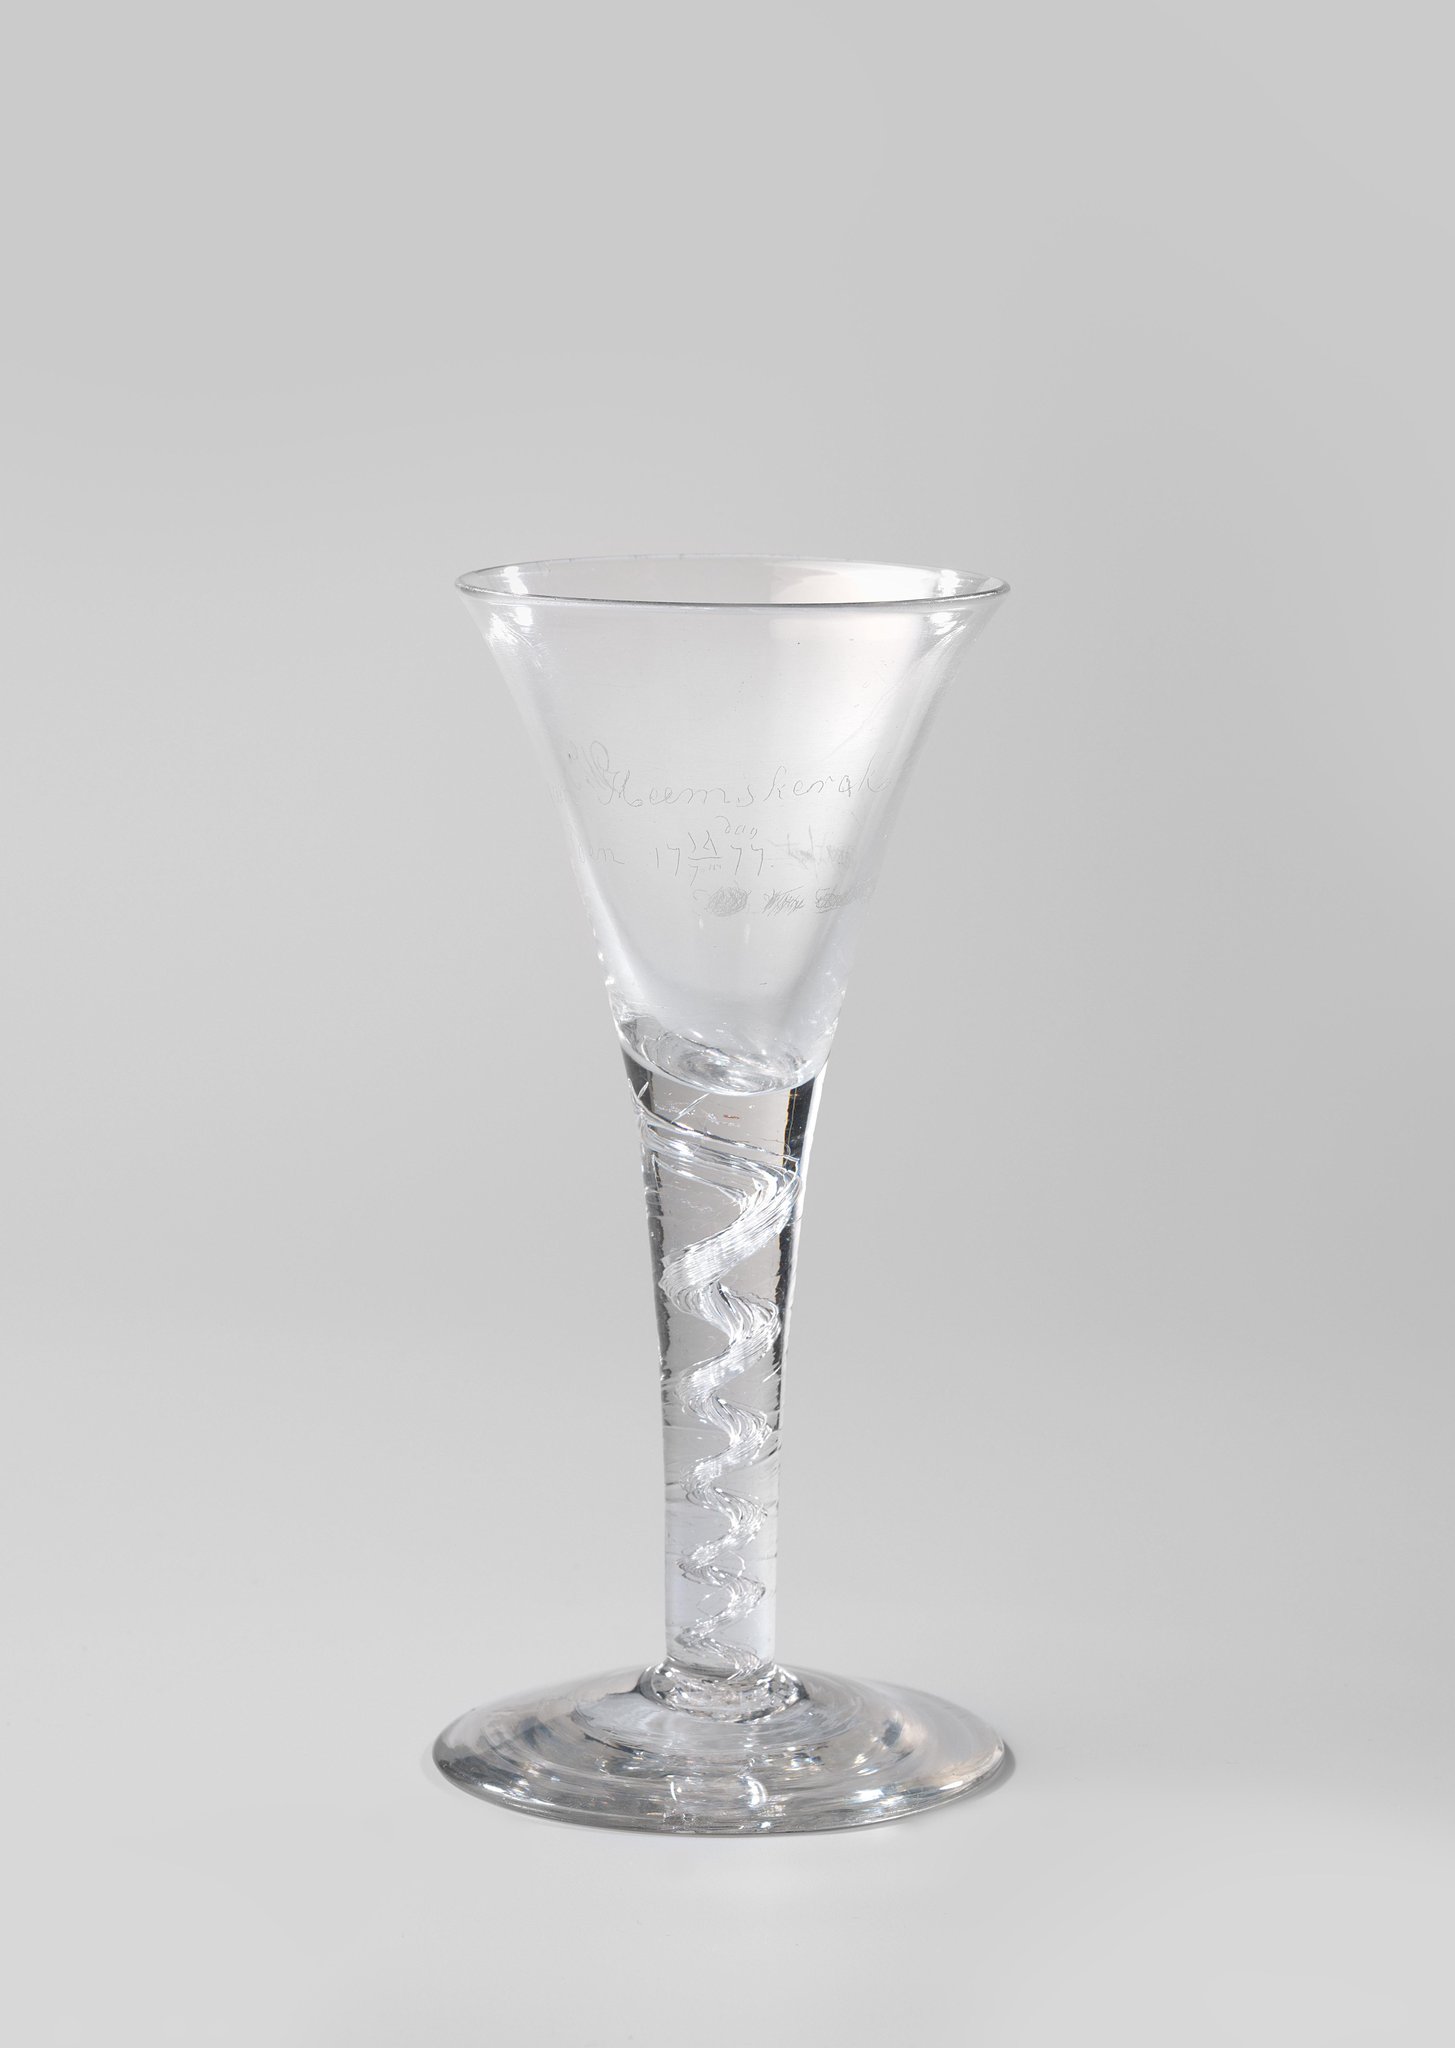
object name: goblet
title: Slingerglas met het opschrift: W.A. van Heemskerck den 17 14dag 77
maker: Anonymous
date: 1777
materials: glass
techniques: diamond point engraving, glassblowing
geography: england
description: Konische voet met pontilmerk. Zich verjongende stam, die overgaat in een trompetvormige kelk. In de stam een luchtslinger. Op de kelk is de naam en datum 'W.A. van Heemskerck den 17 14dag 77' gegraveerd. 7m. Rechts onder de naam een twee doorgekrast opschrift --